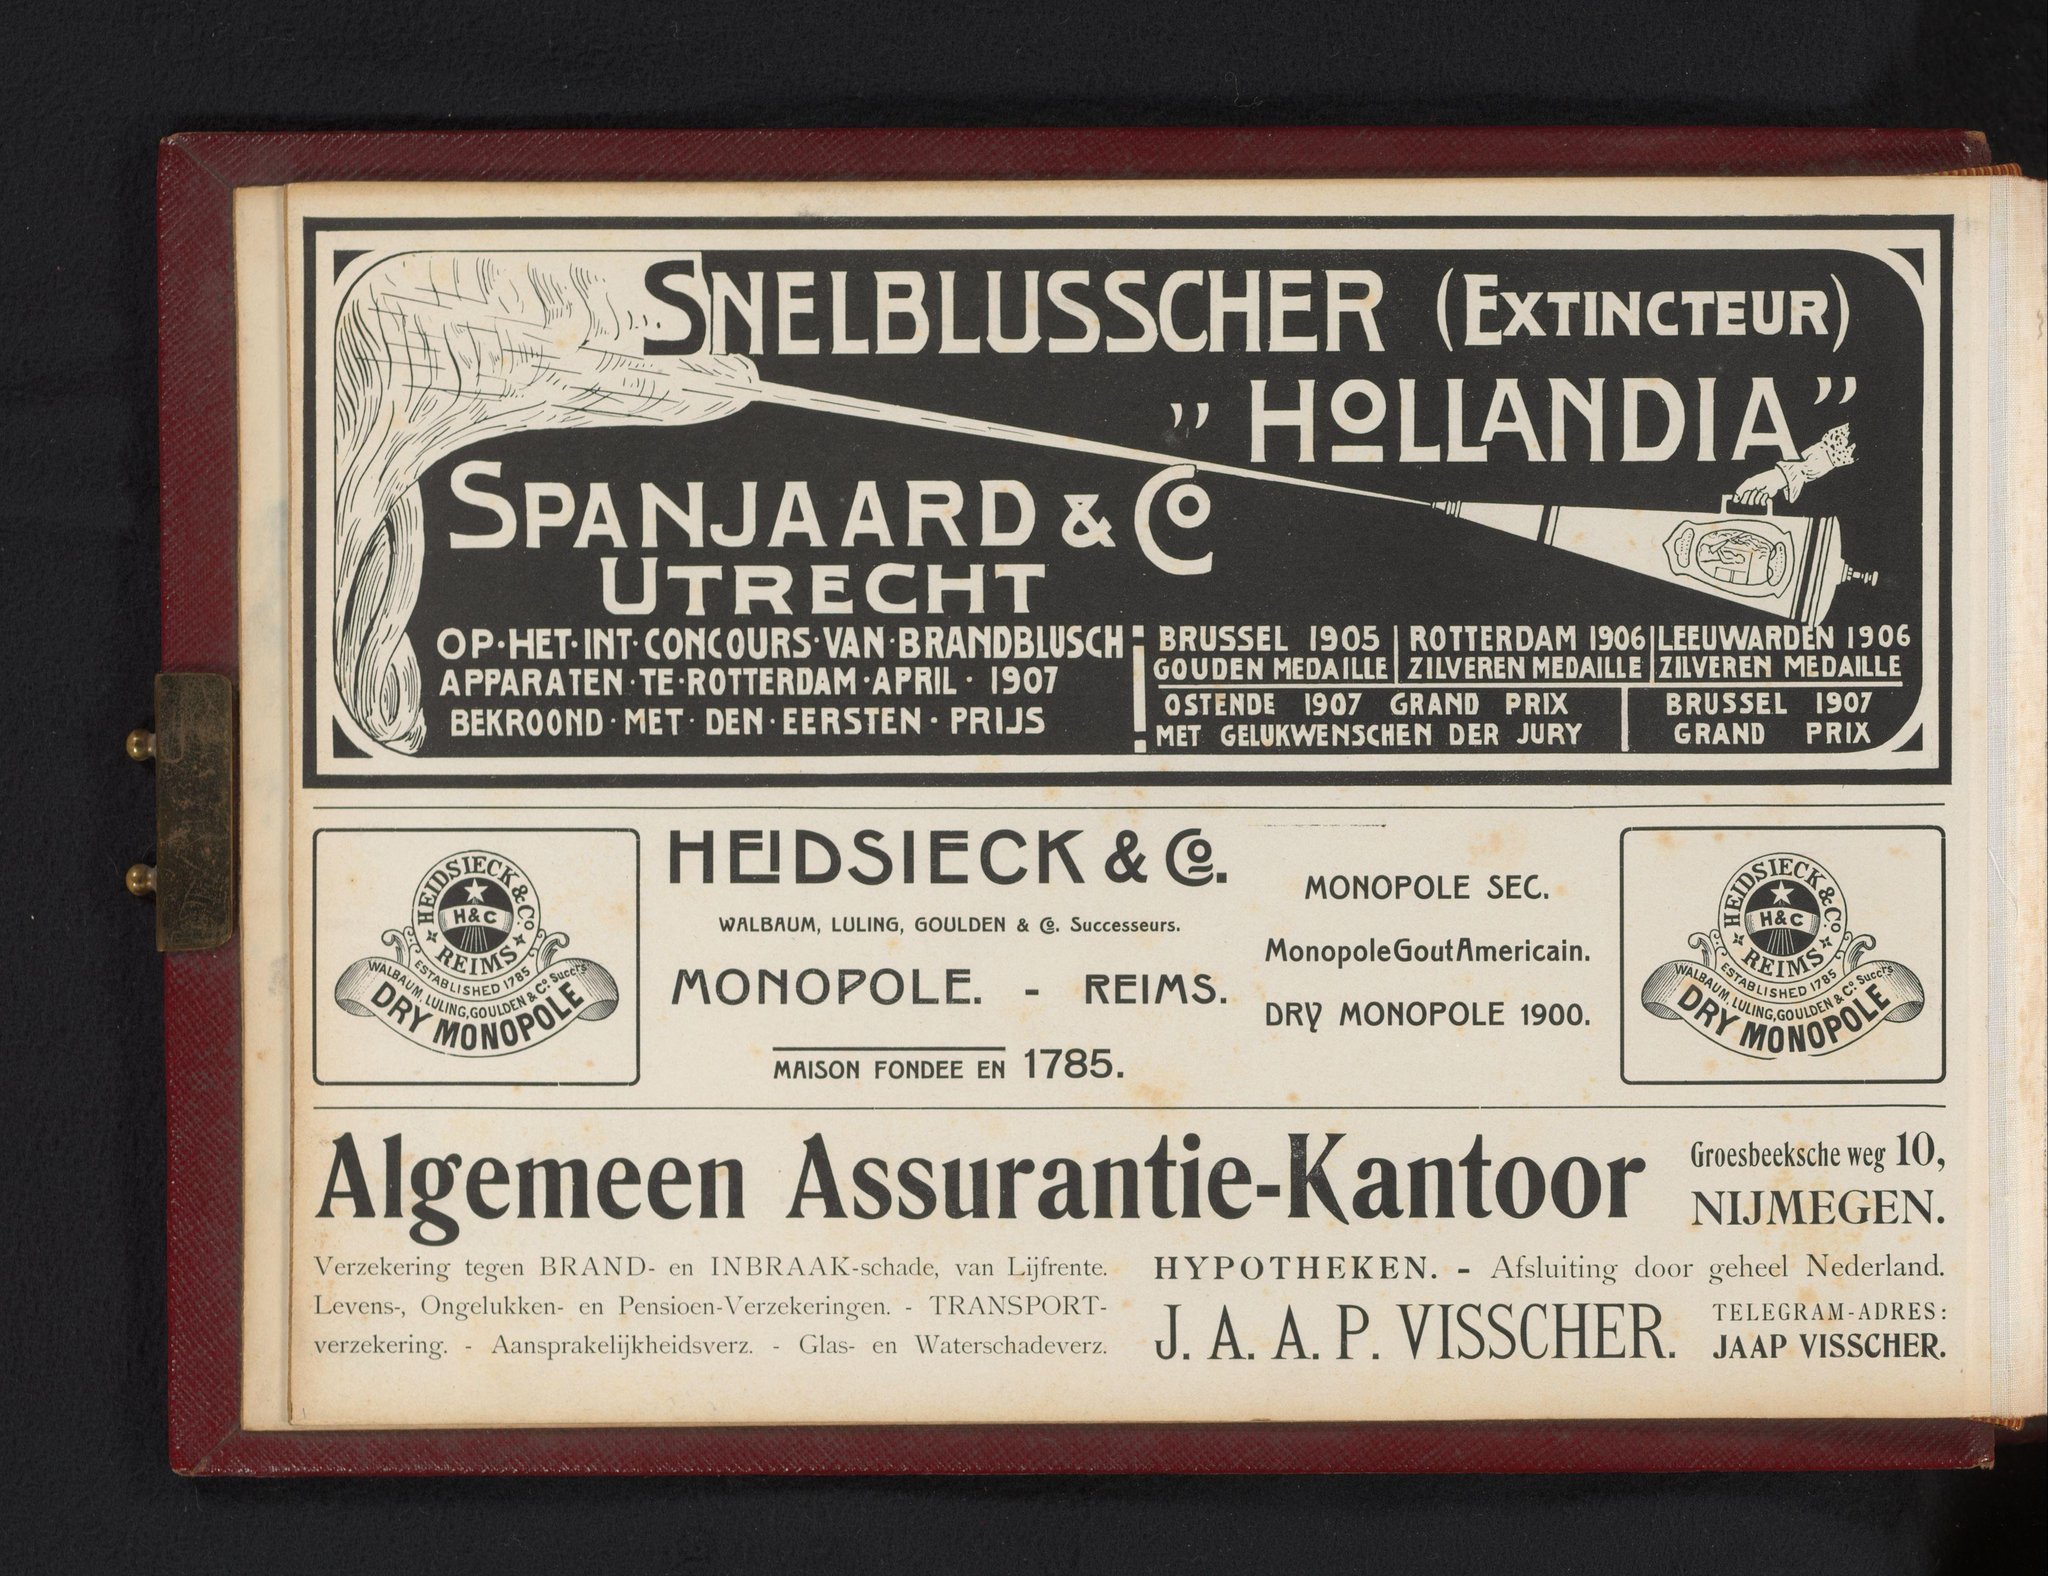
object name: album leaf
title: Advertenties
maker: Anonymous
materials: paper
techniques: printing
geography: netherlands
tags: advertising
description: Advertenties voor onder andere Snelblusscher "Hollandia", Heidsieck & Co./ Algemeen Assurantie Kantoor en J.A.A.P. Visscher. Deze pagina maakt deel uit van een album.